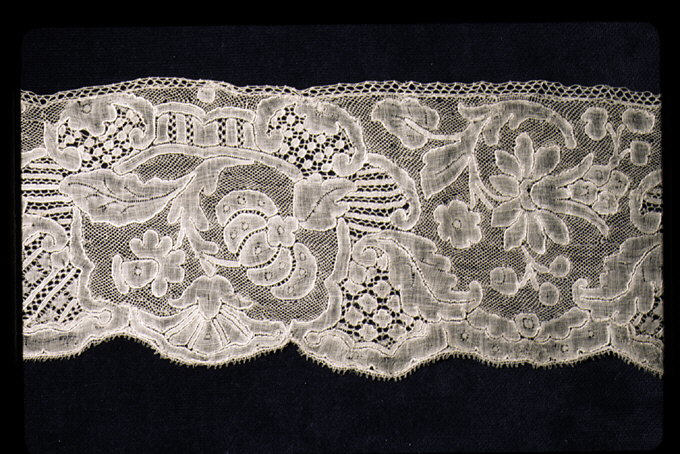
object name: fragment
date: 1701-1800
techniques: lace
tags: leaves